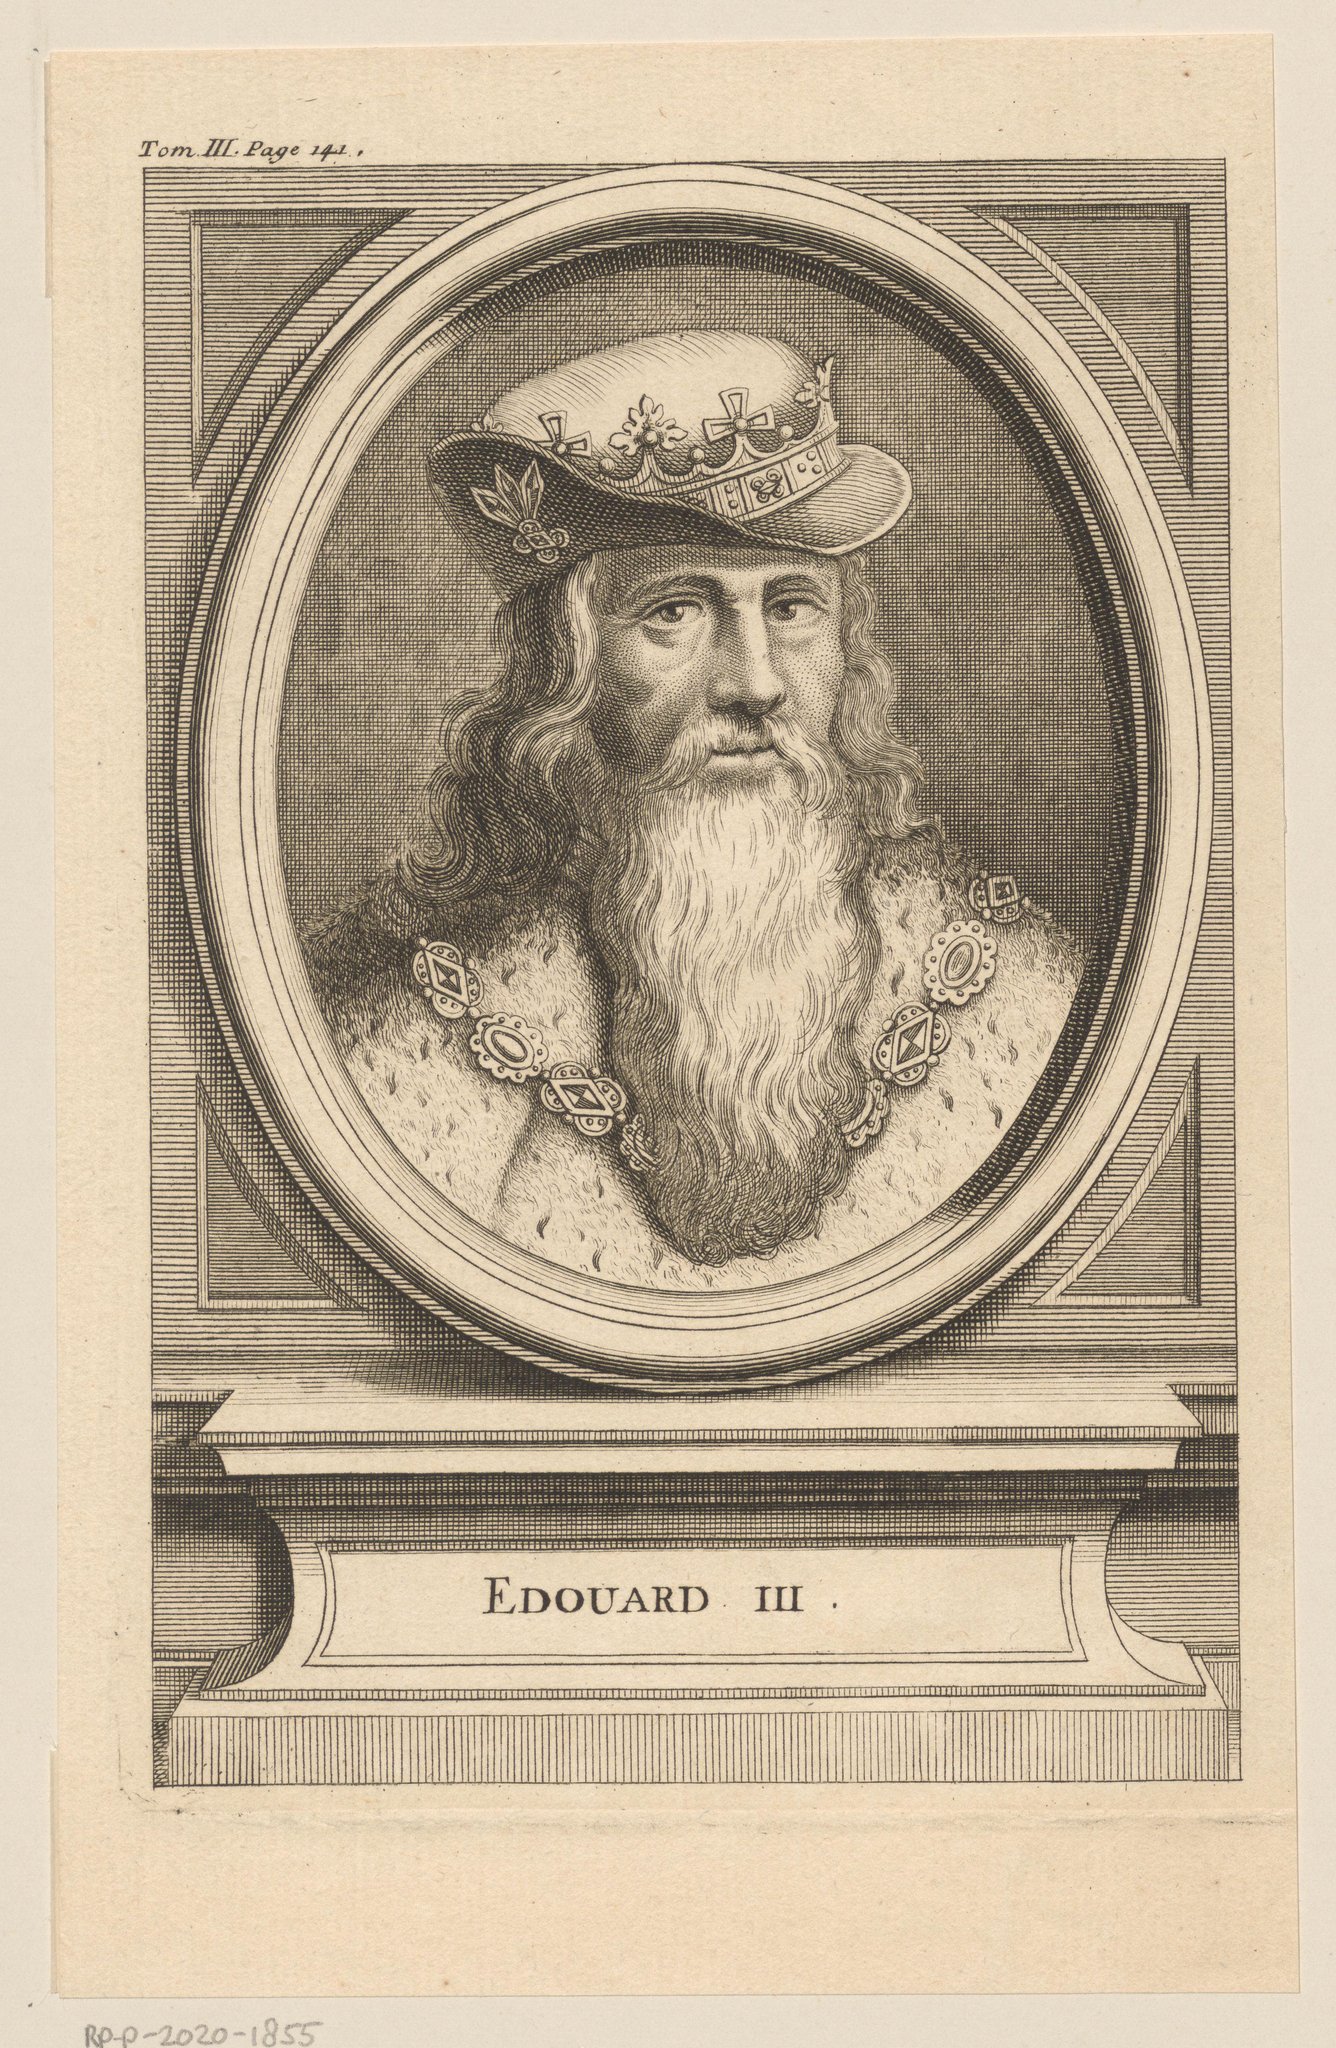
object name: book illustration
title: Portret van Eduard III van Engeland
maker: Anonymous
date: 1700-1750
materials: paper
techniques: engraving, etching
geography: france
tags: crown (symbol of sovereignty), historical persons, king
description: Prent komt uit een onbekende publicatie.